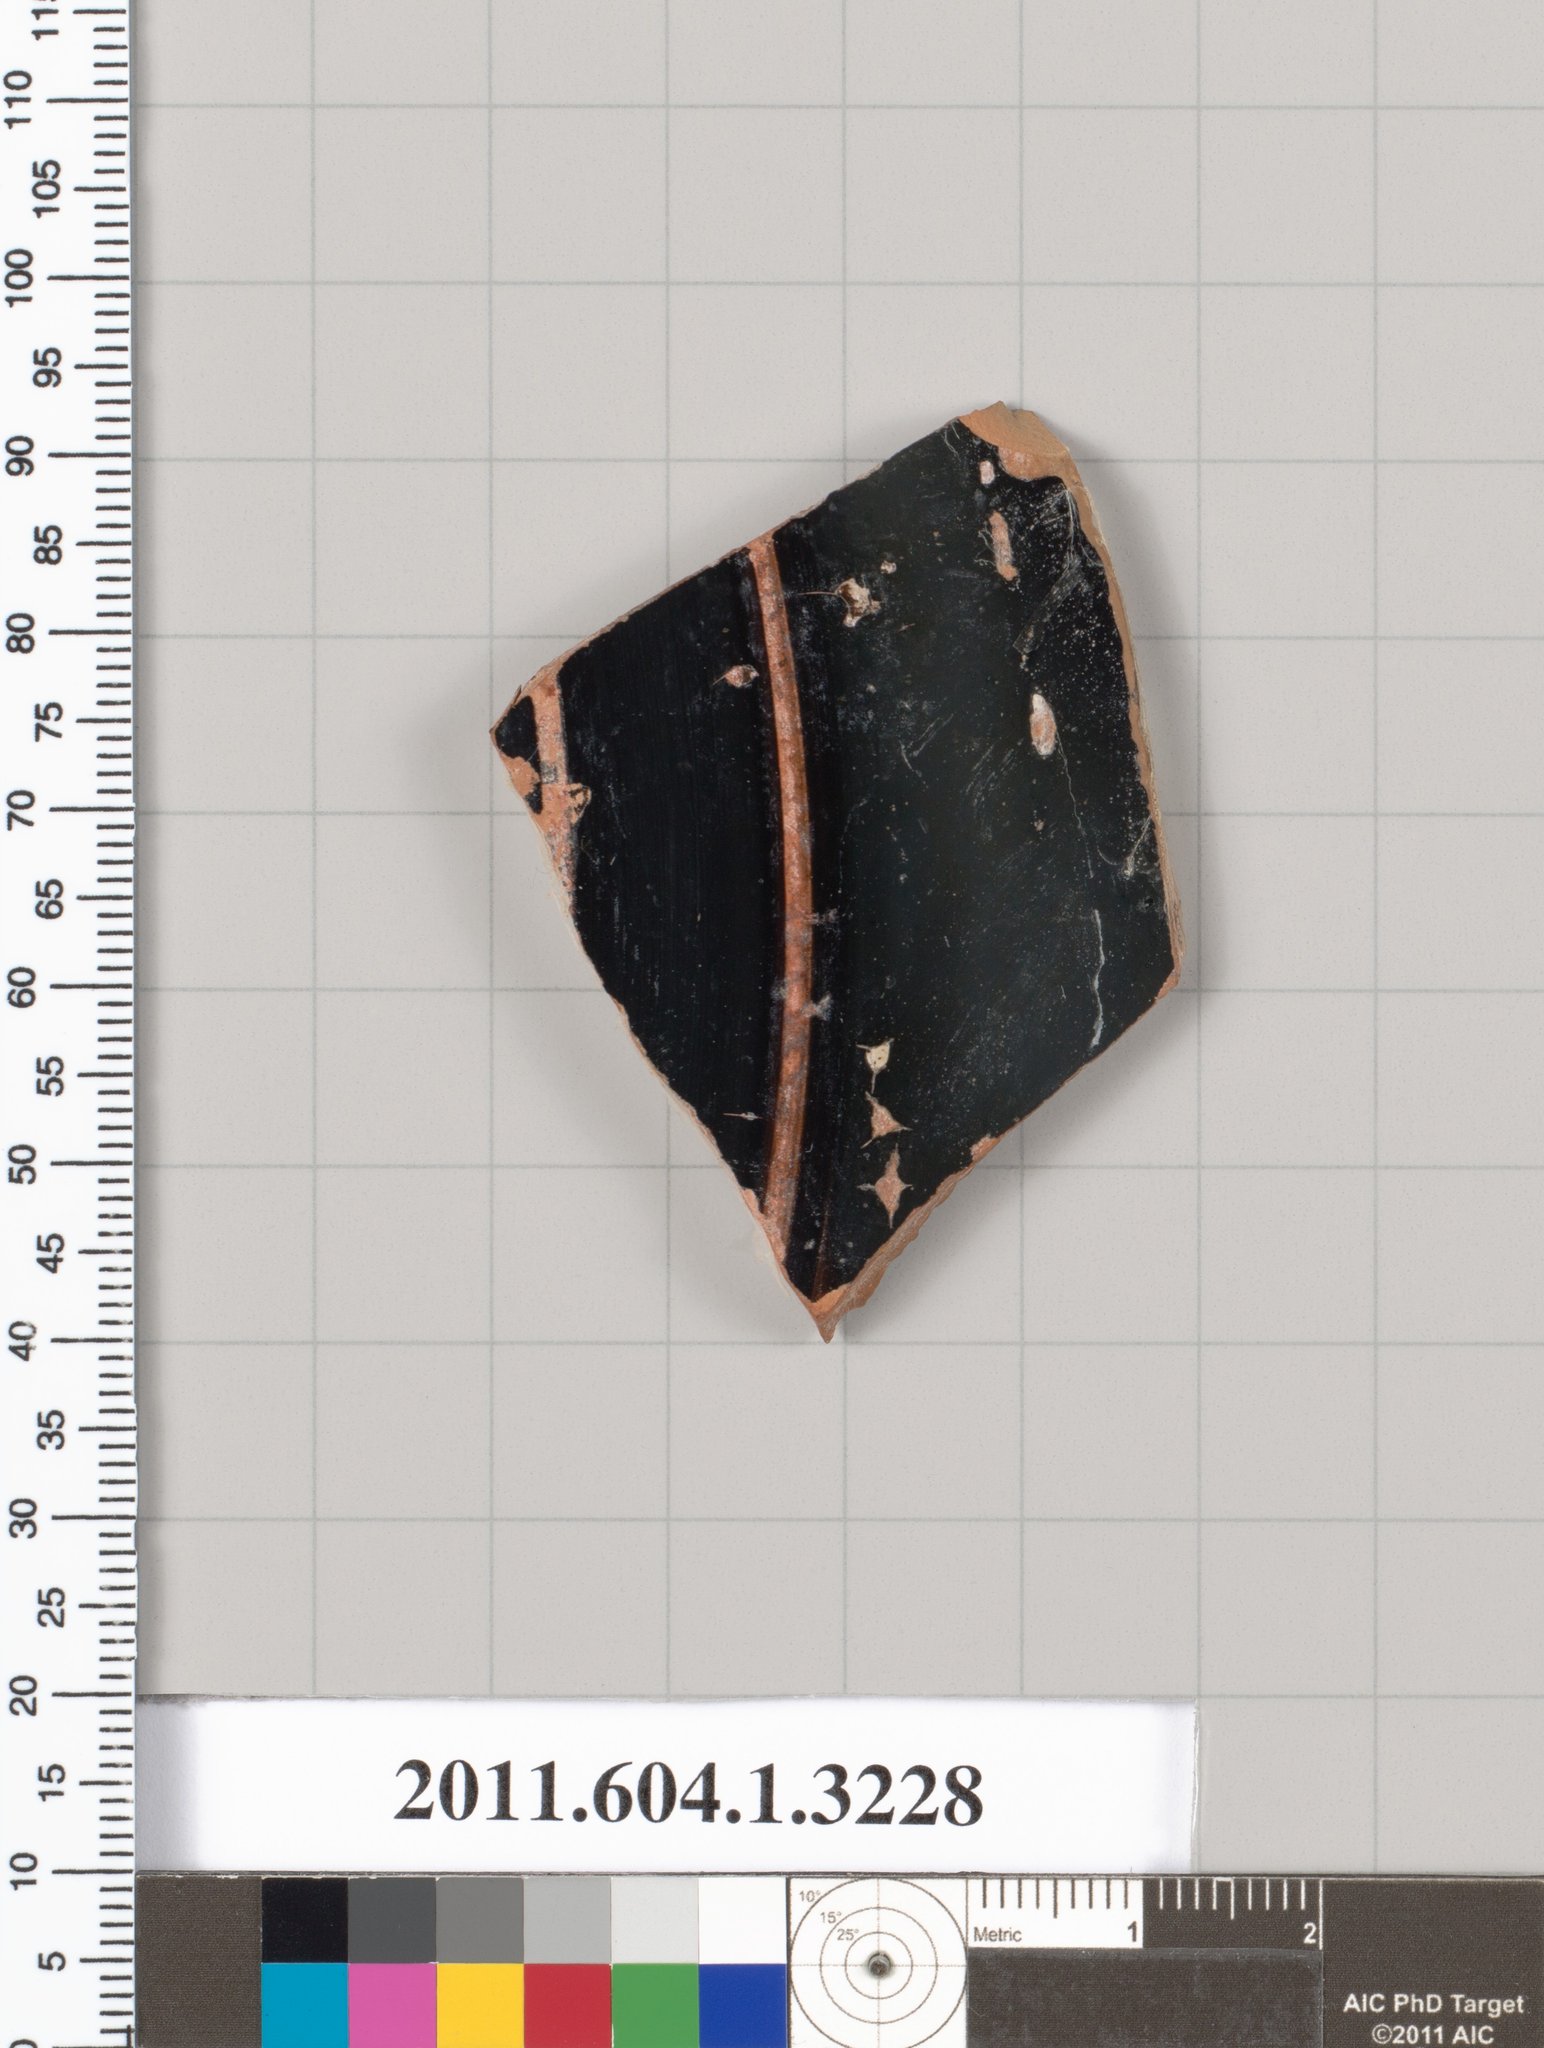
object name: kylix fragment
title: Terracotta fragment of a kylix (drinking cup)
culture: greek, attic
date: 600-401 BCE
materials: terracotta